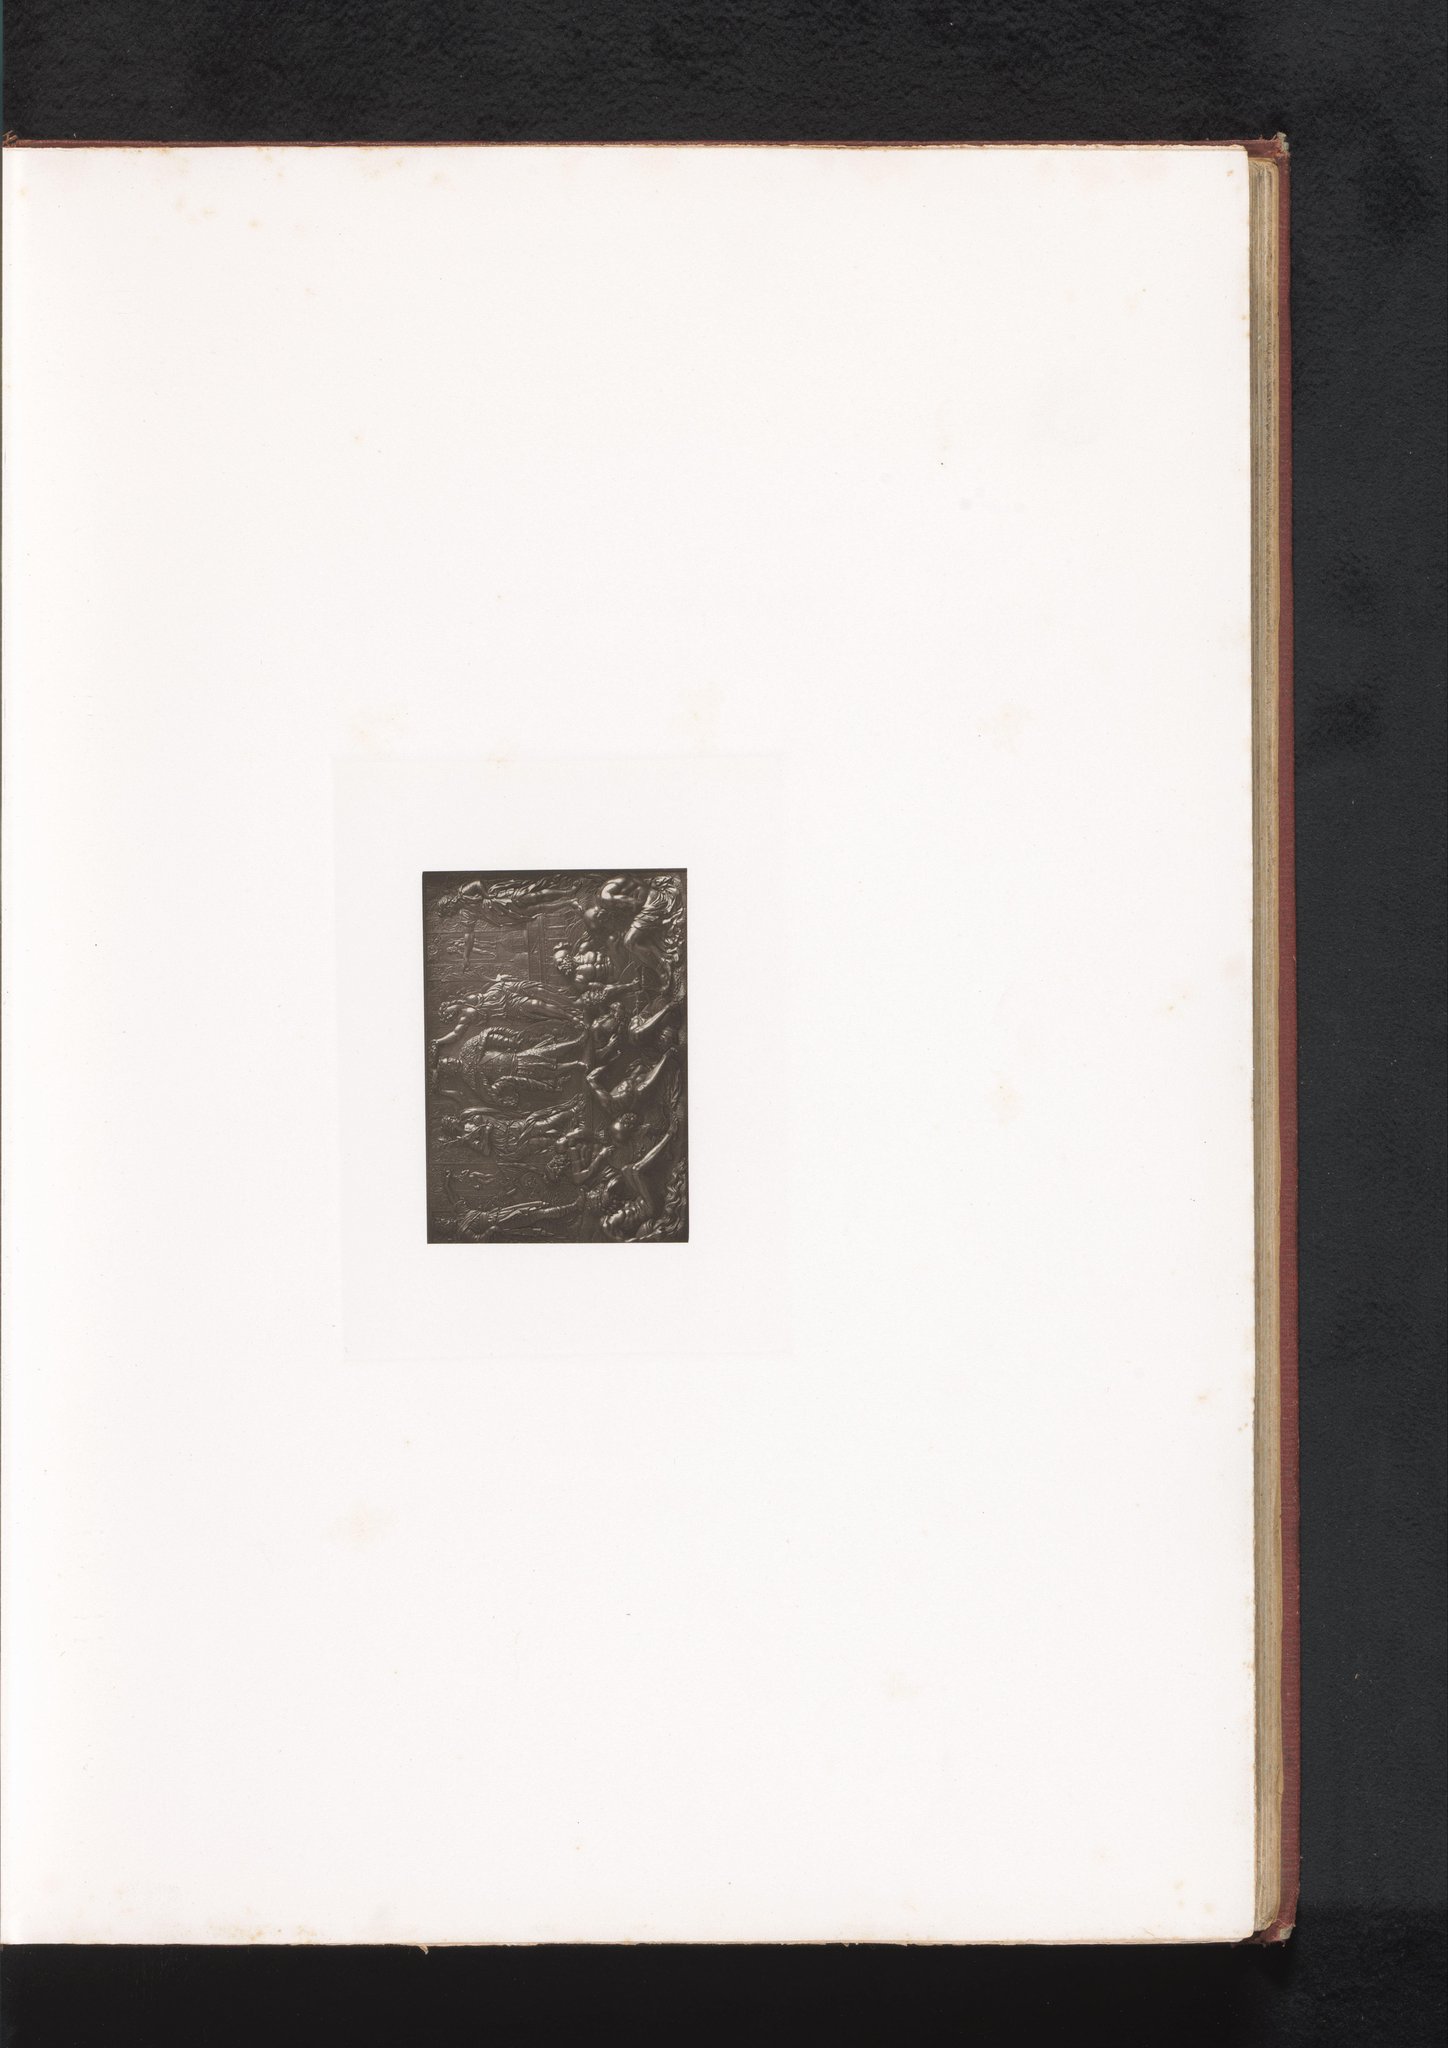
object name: photomechanical print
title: Eikenhouten reliëf, afgebeeld de apotheose van Jan Sobieski tijdens het Beleg van Wenen in 1683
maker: gabriel blaise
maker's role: printer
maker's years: 1827-1897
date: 1868-1873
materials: paper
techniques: woodburytype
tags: battle, piece of sculpture, reproduction of a piece of sculpture